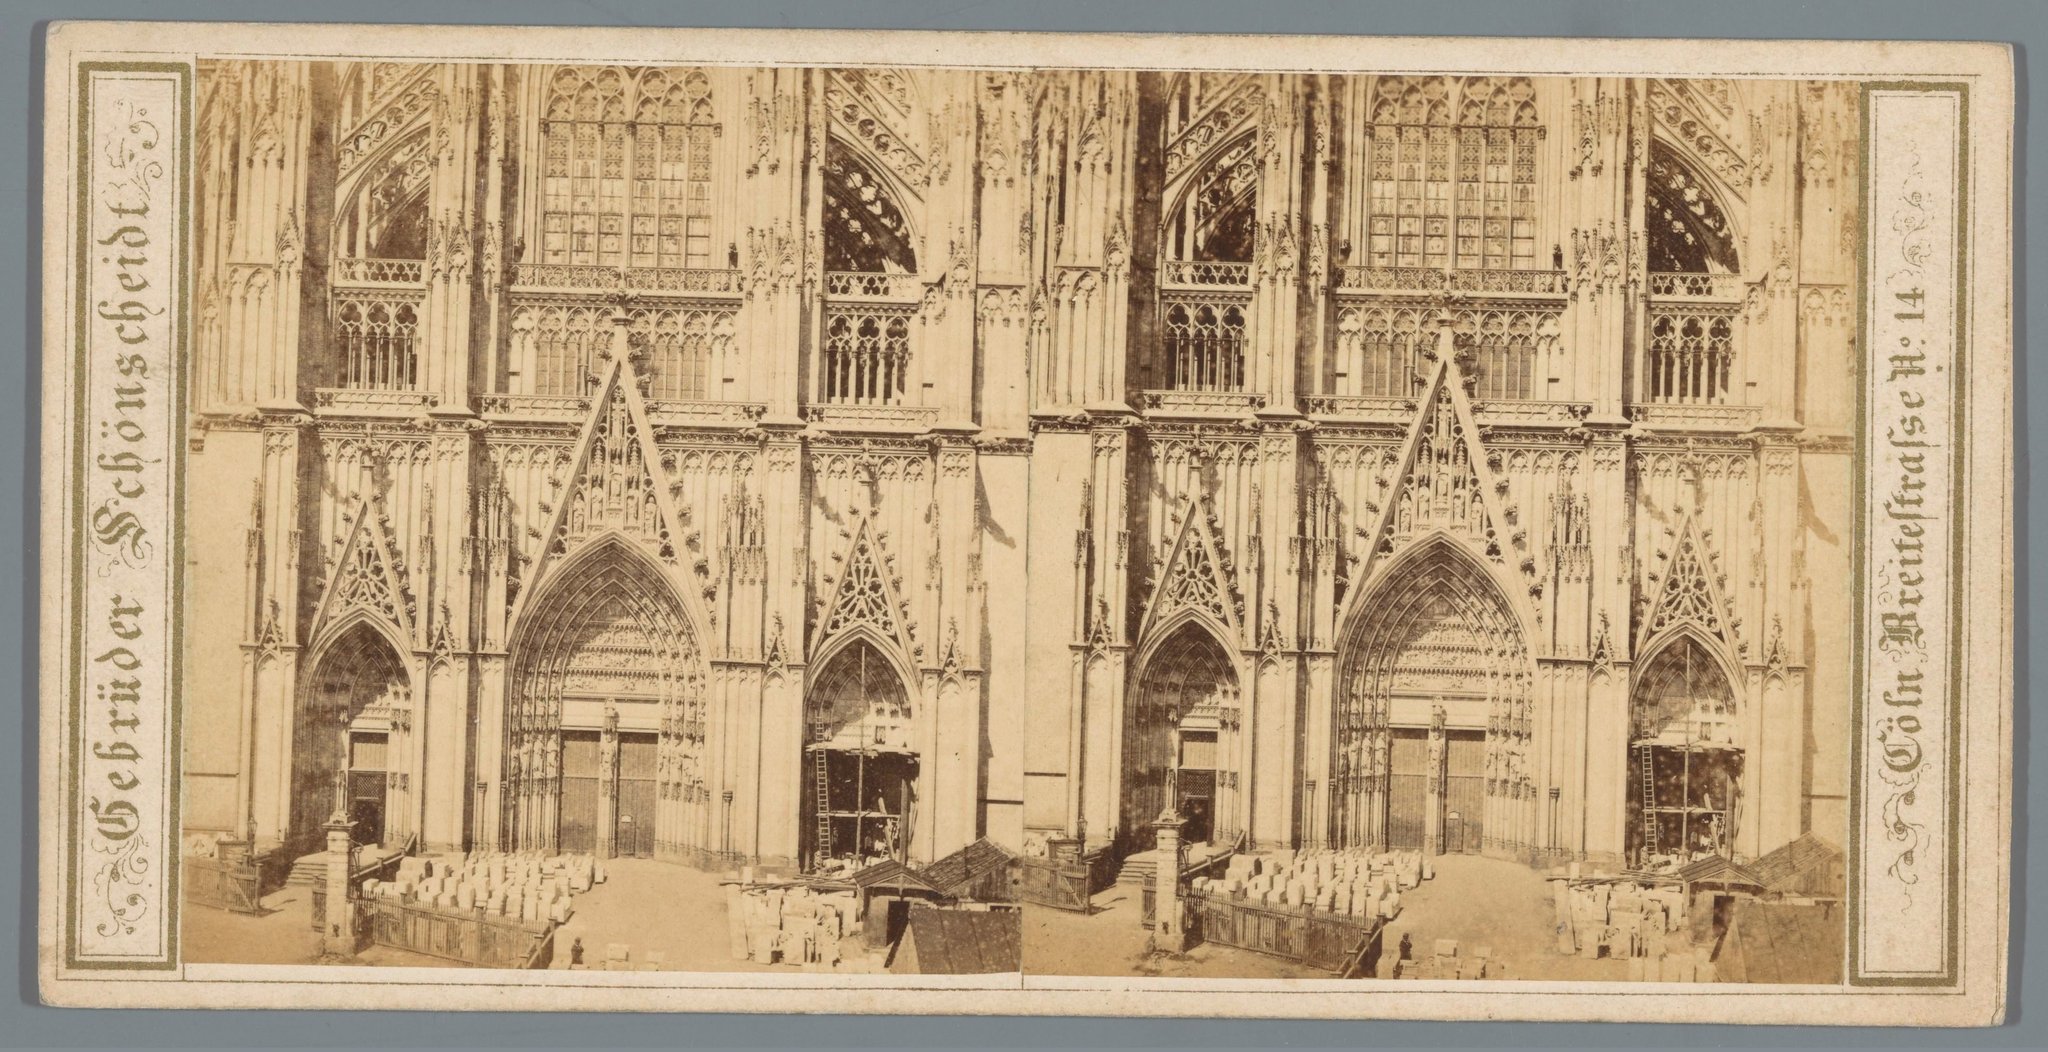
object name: stereograph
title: Voorgevel van de Dom van Keulen, tijdens de restauratie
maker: johann heinrich schönscheidt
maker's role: fotograaf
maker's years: 1835-1903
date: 1862-1869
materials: cardboard, paper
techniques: albumen print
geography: cologne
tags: parts of church exterior and annexes: façade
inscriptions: inscription: ‘geschenk MB’, inscription: ‘N 2,8 M Oreinie [?]’, number: ‘400. C60.’, inscription: ‘Portal of the Cologn Cathedral.’